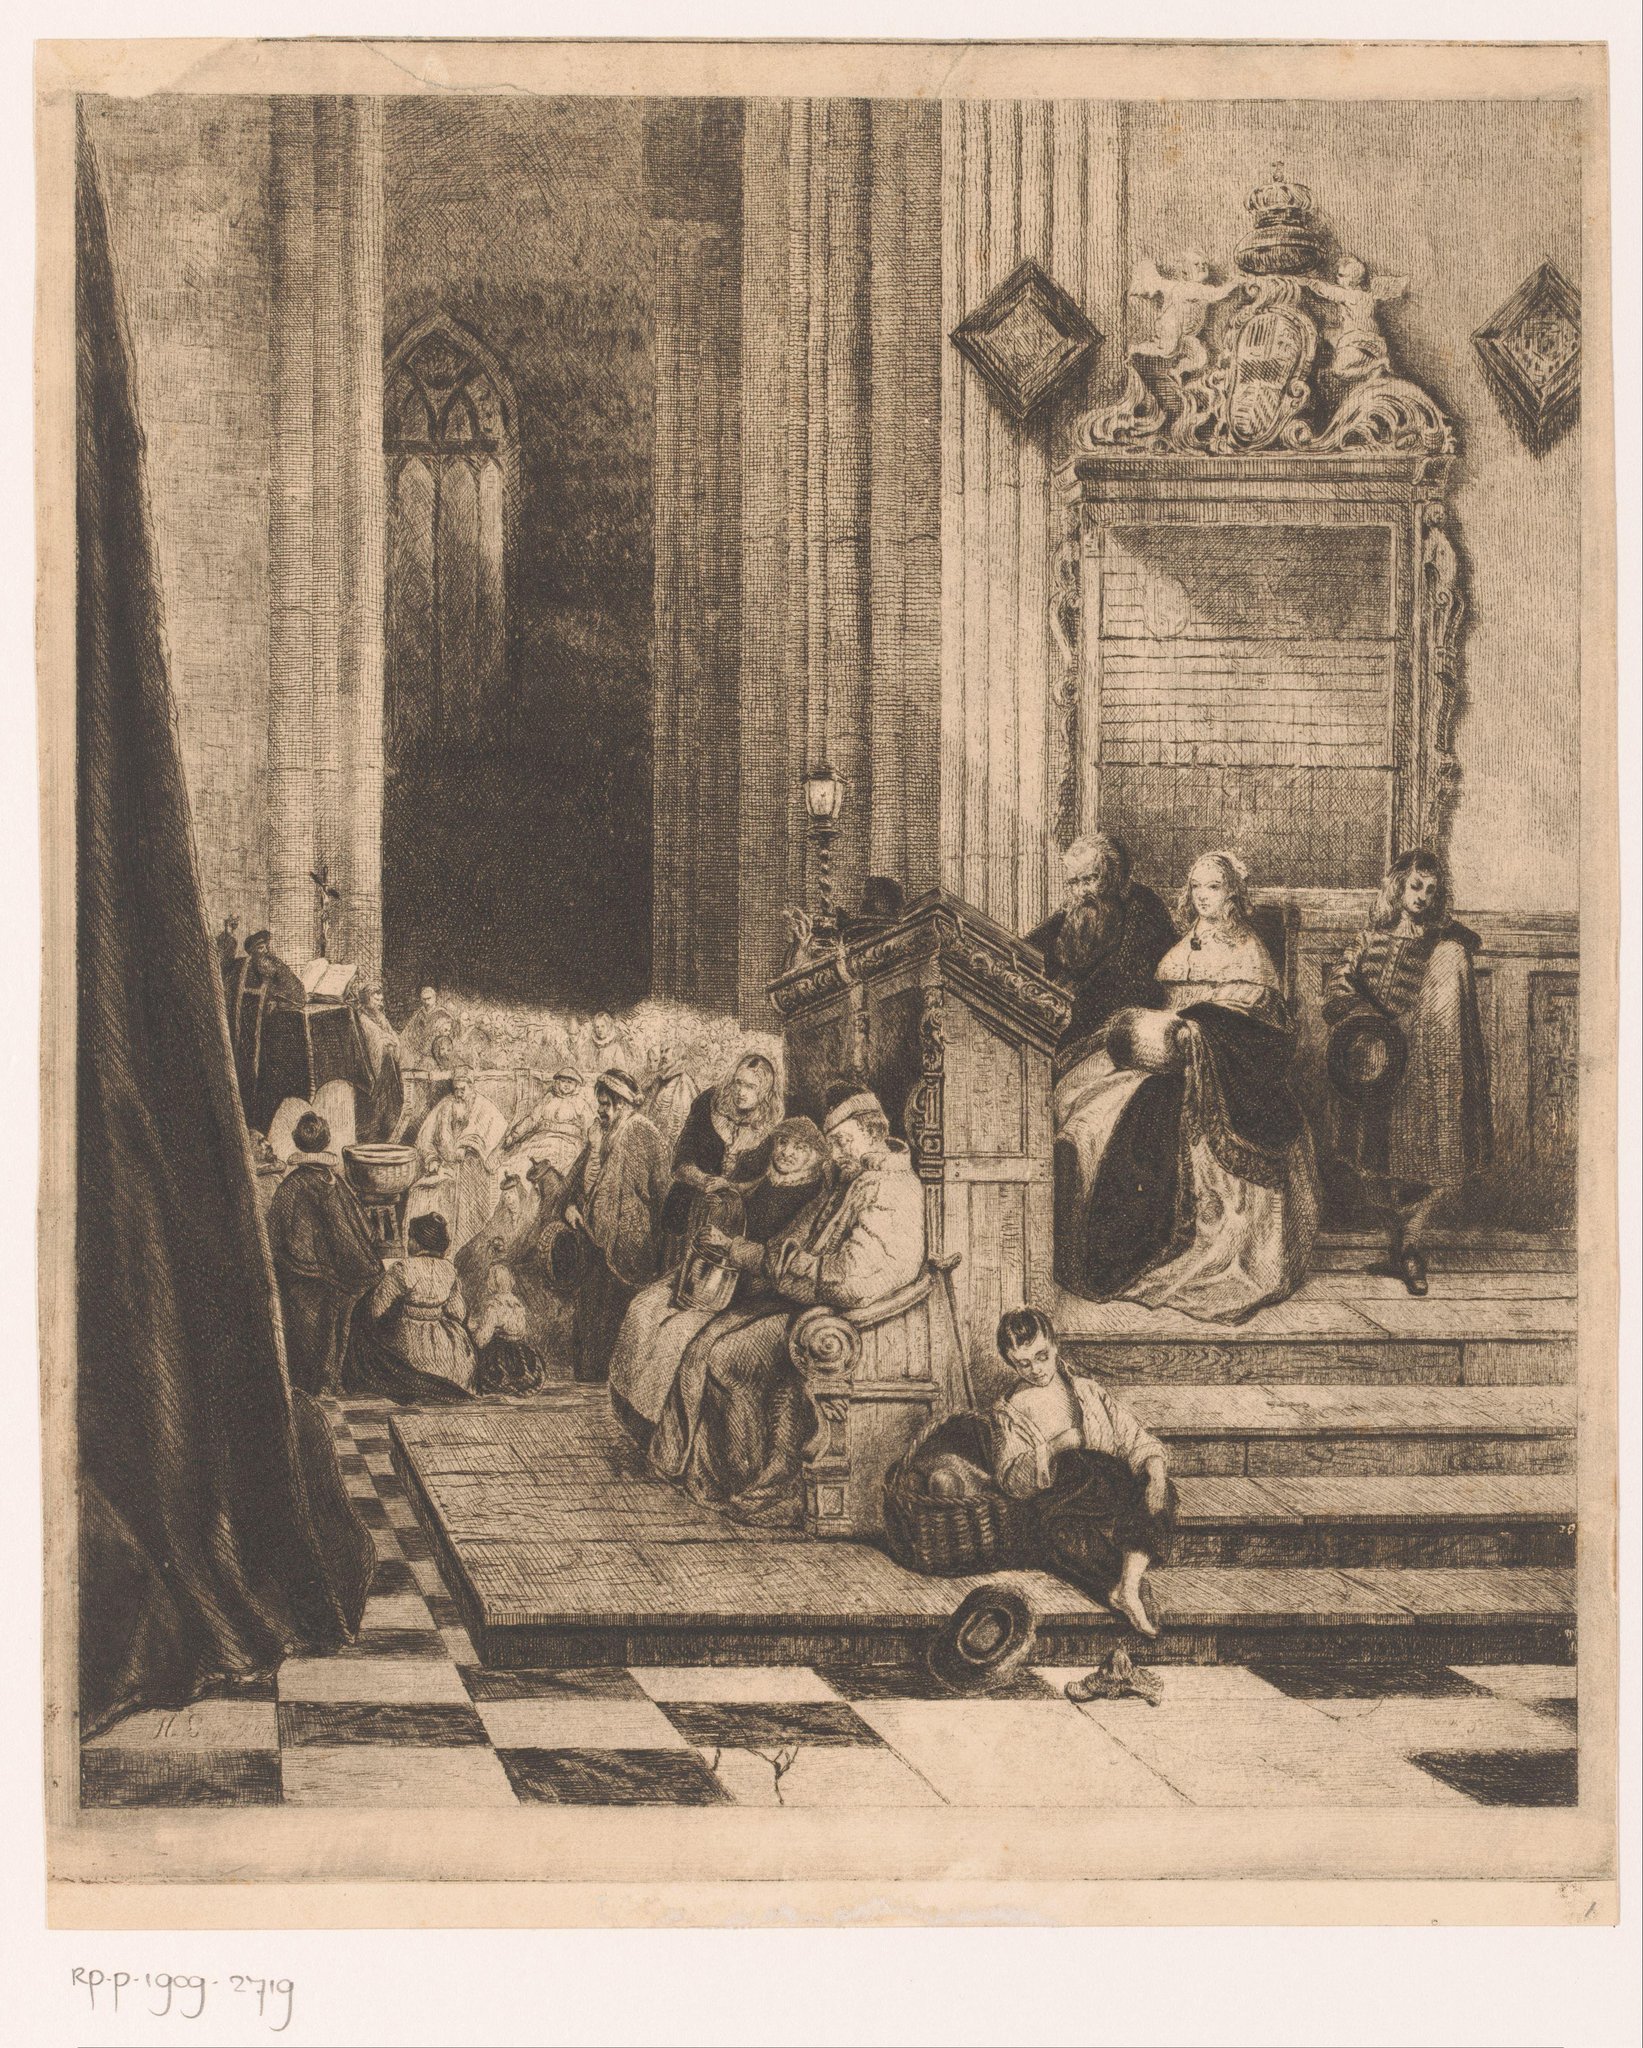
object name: print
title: Interieur van een kerk tijdens de preek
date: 1824-1853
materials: paper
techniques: etching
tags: interior of church, preaching (in general)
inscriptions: collector's mark: Lugt 2228